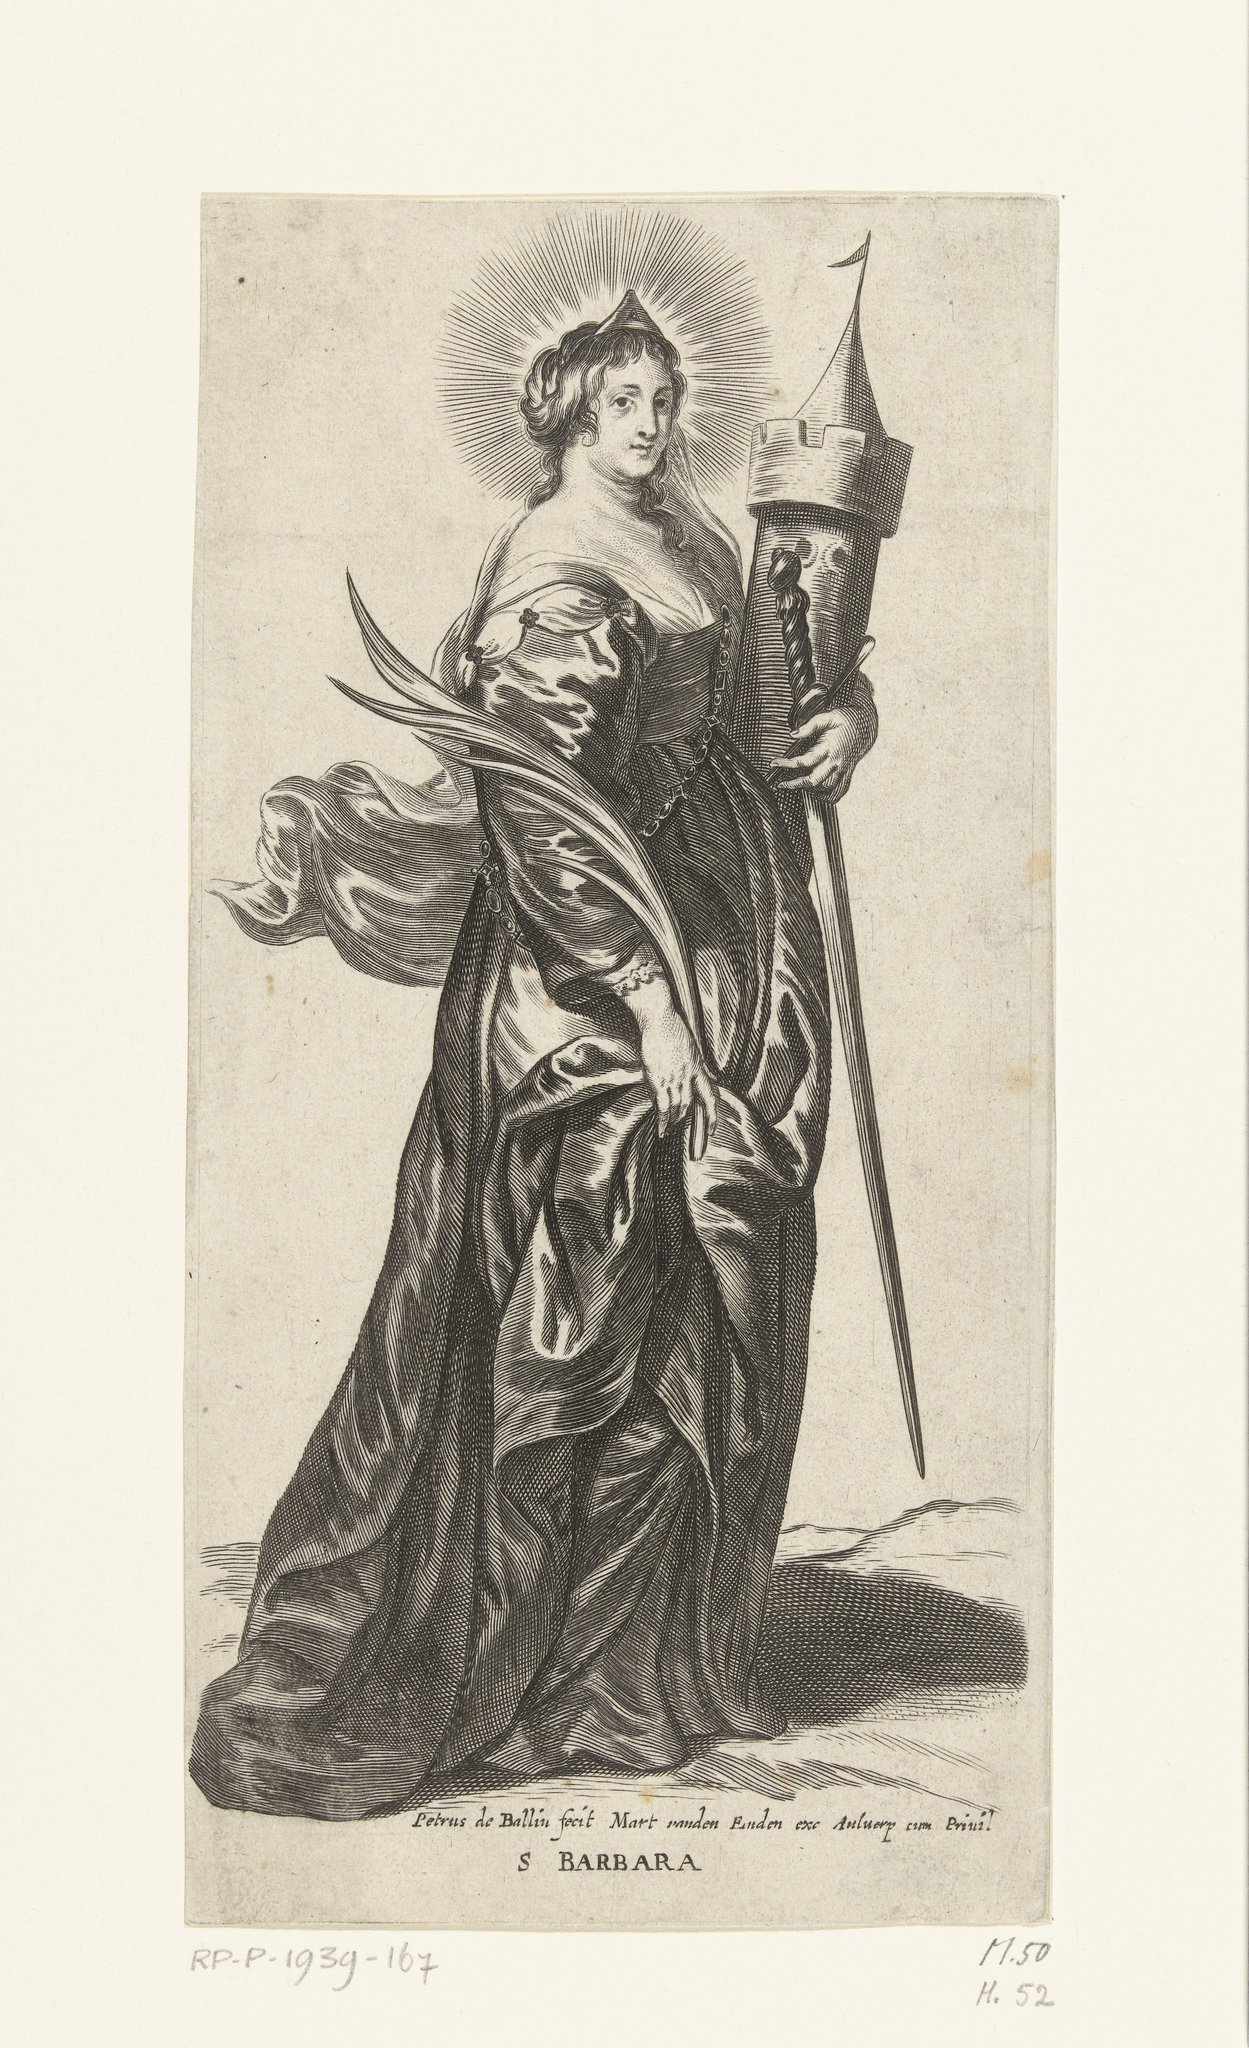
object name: print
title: S Barbara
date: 1623-1660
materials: paper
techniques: engraving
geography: antwerp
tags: the virgin martyr barbara; possible attributes: book, cannon(ball), crown, cross, chalice with wafer, dioscuros (her father), peacock feather, sword, torches, mason's tools, tower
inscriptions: collector's mark: Lugt 2228